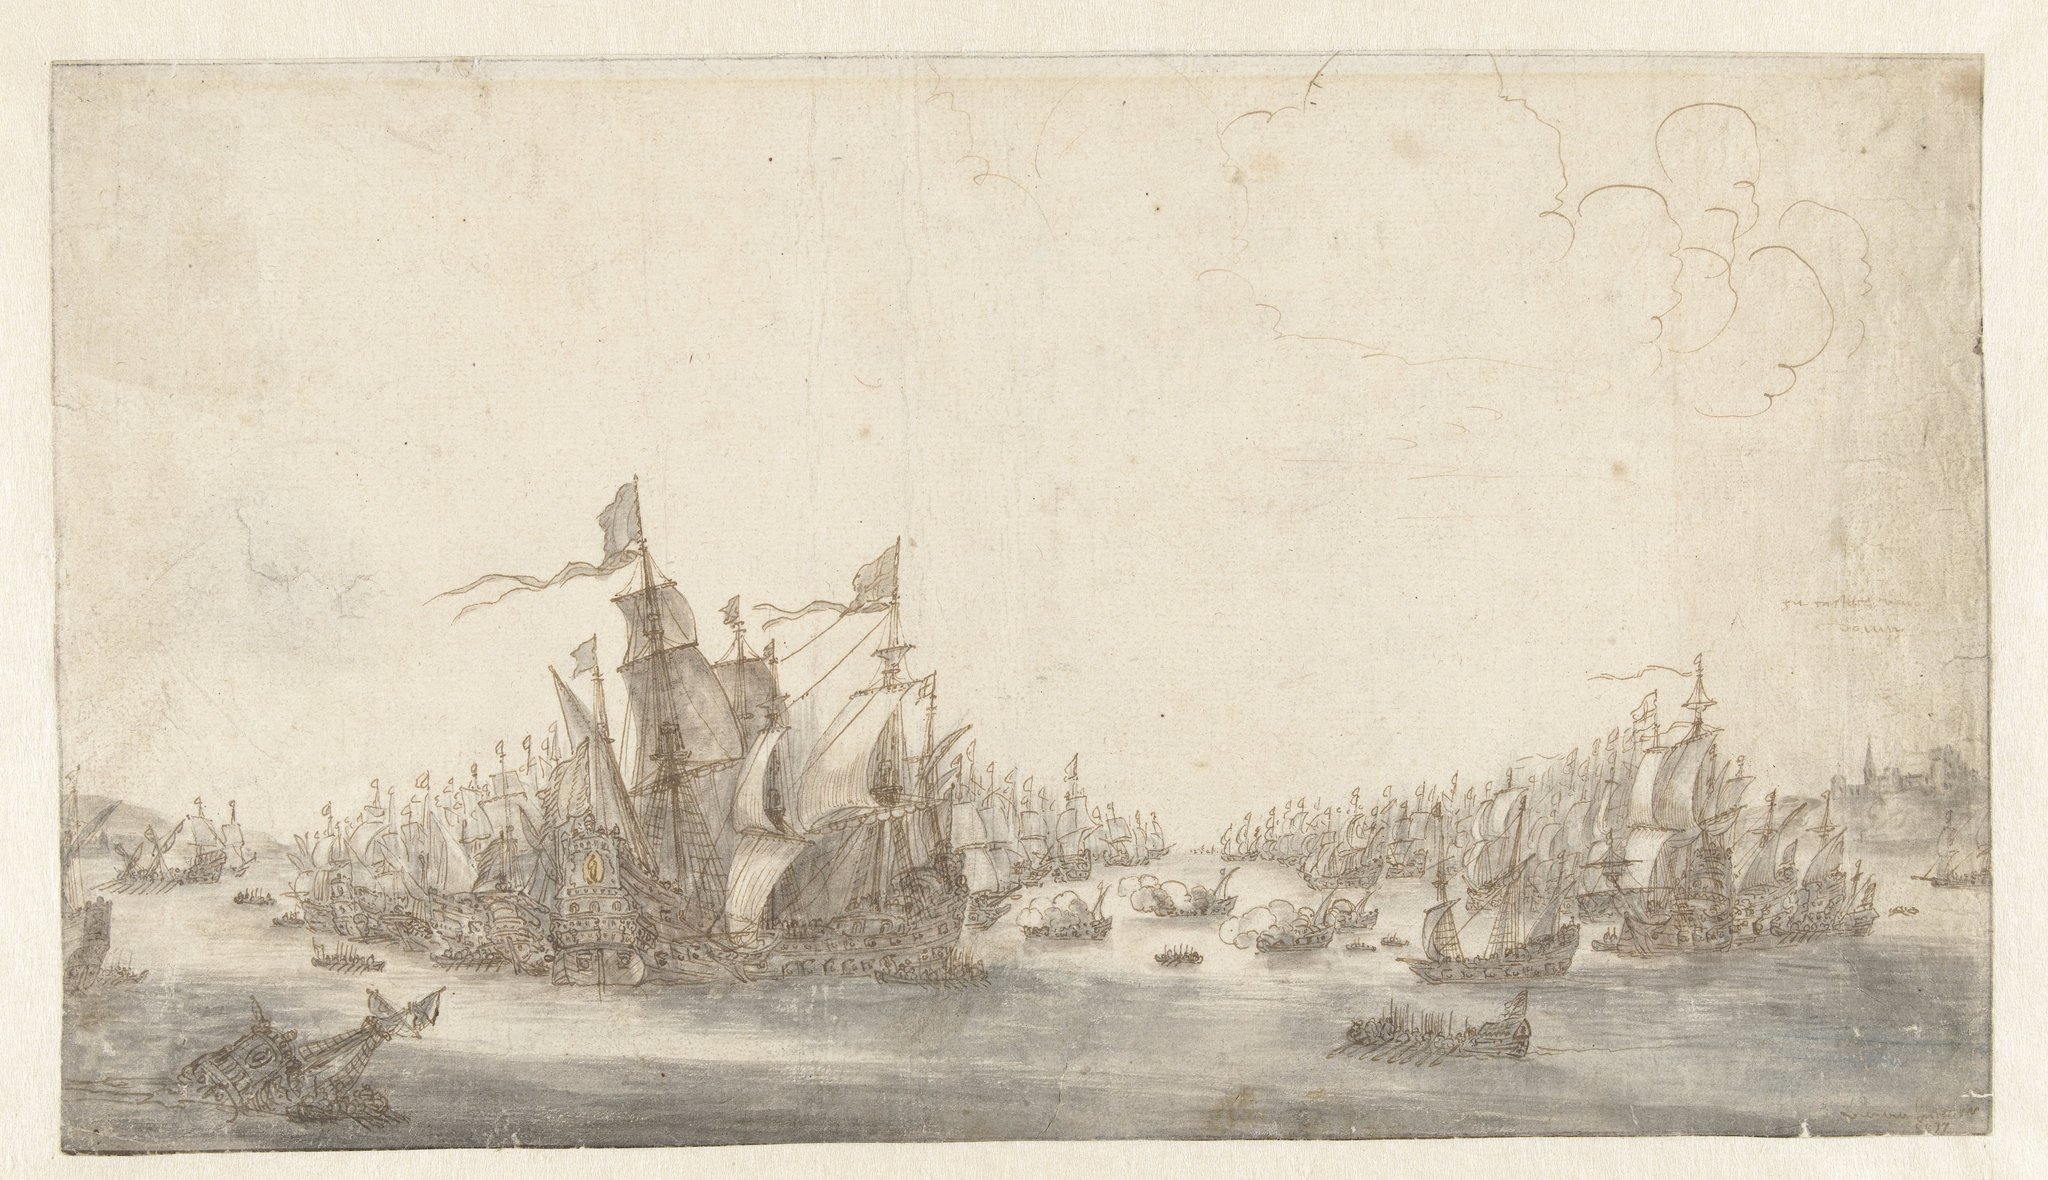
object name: drawing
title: De zeeslag bij Duins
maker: abraham de verwer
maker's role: draughtsman, painter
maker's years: 1585-1650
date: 1639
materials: ink, paper, pencil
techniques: brush, pen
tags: sailing-ship, sailing-boat, sea (seascape), battle (+ sailing-ships), navy (+ sailing-ships), historical events and situations, battle of the downs